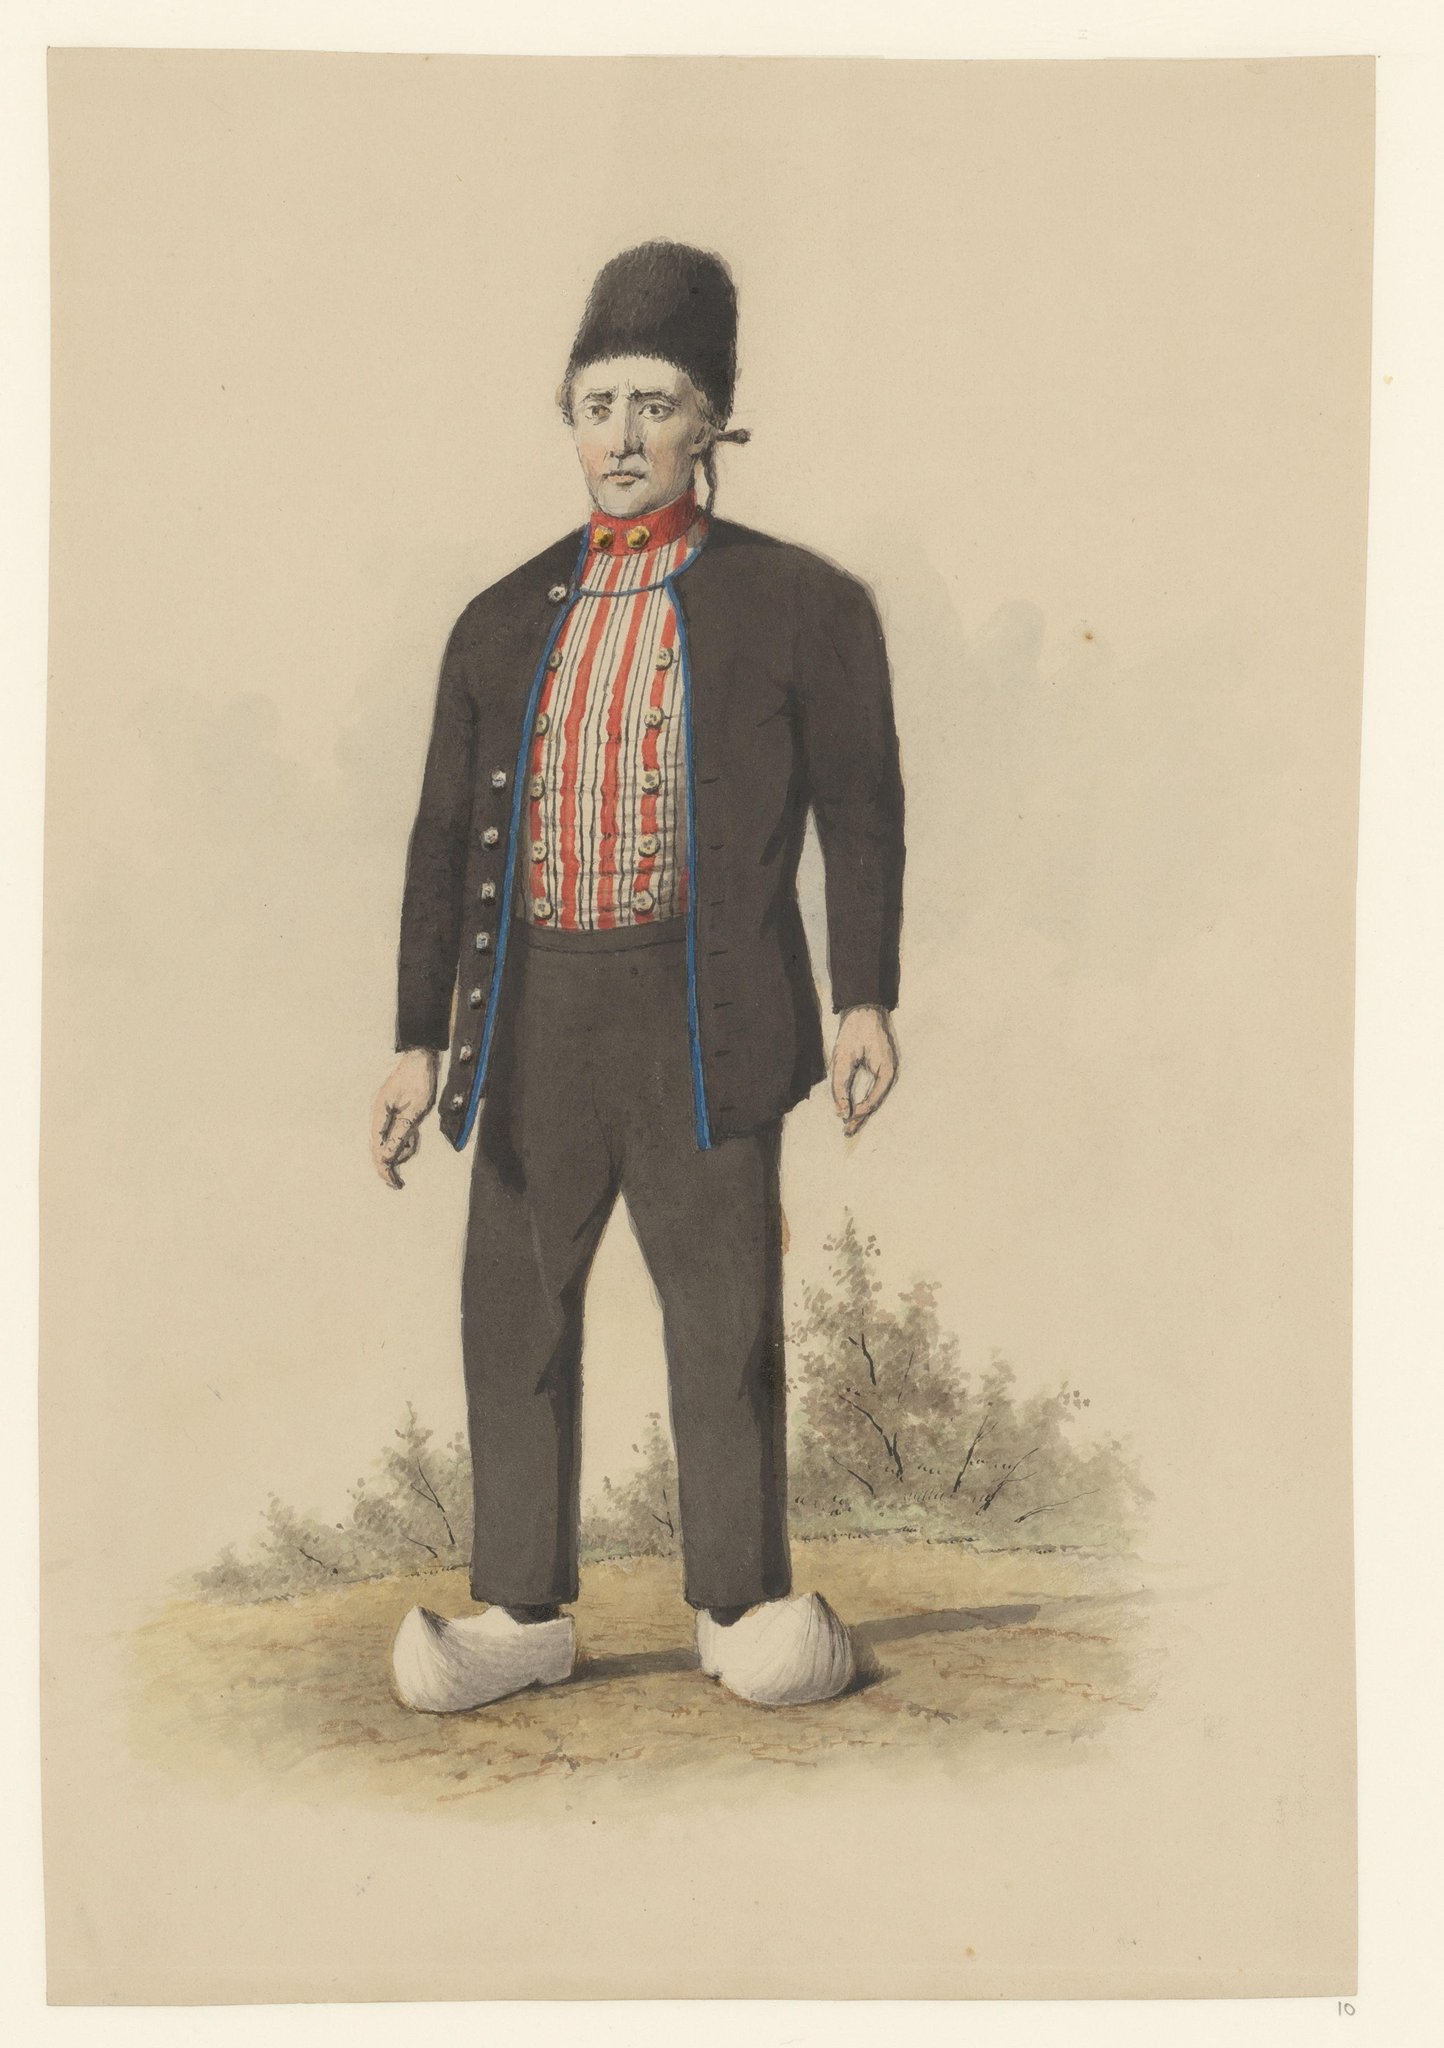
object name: drawing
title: Visser van Schokland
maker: johan martinus anthon rieke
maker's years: 1851-1899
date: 1896-1898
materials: paper, watercolor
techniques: brush, hand coloring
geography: netherlands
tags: sea and coastal fishery (+ men (labourers)), clothes, costume (+ men's clothes), folk costume, regional costume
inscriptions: collector's mark: Lugt 1641, collector's mark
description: Visser van Schokland. Tekening vervaardigd voor de tentoonstelling over Nederlandse klederdrachten gehouden in het Stedelijk Museum te Amsterdam in september 1898. Onderwerpsrubrieken binnen de Atlas Zeden en Gewoonten: De Kleeding, Volkskleederdracht, Overijssel.